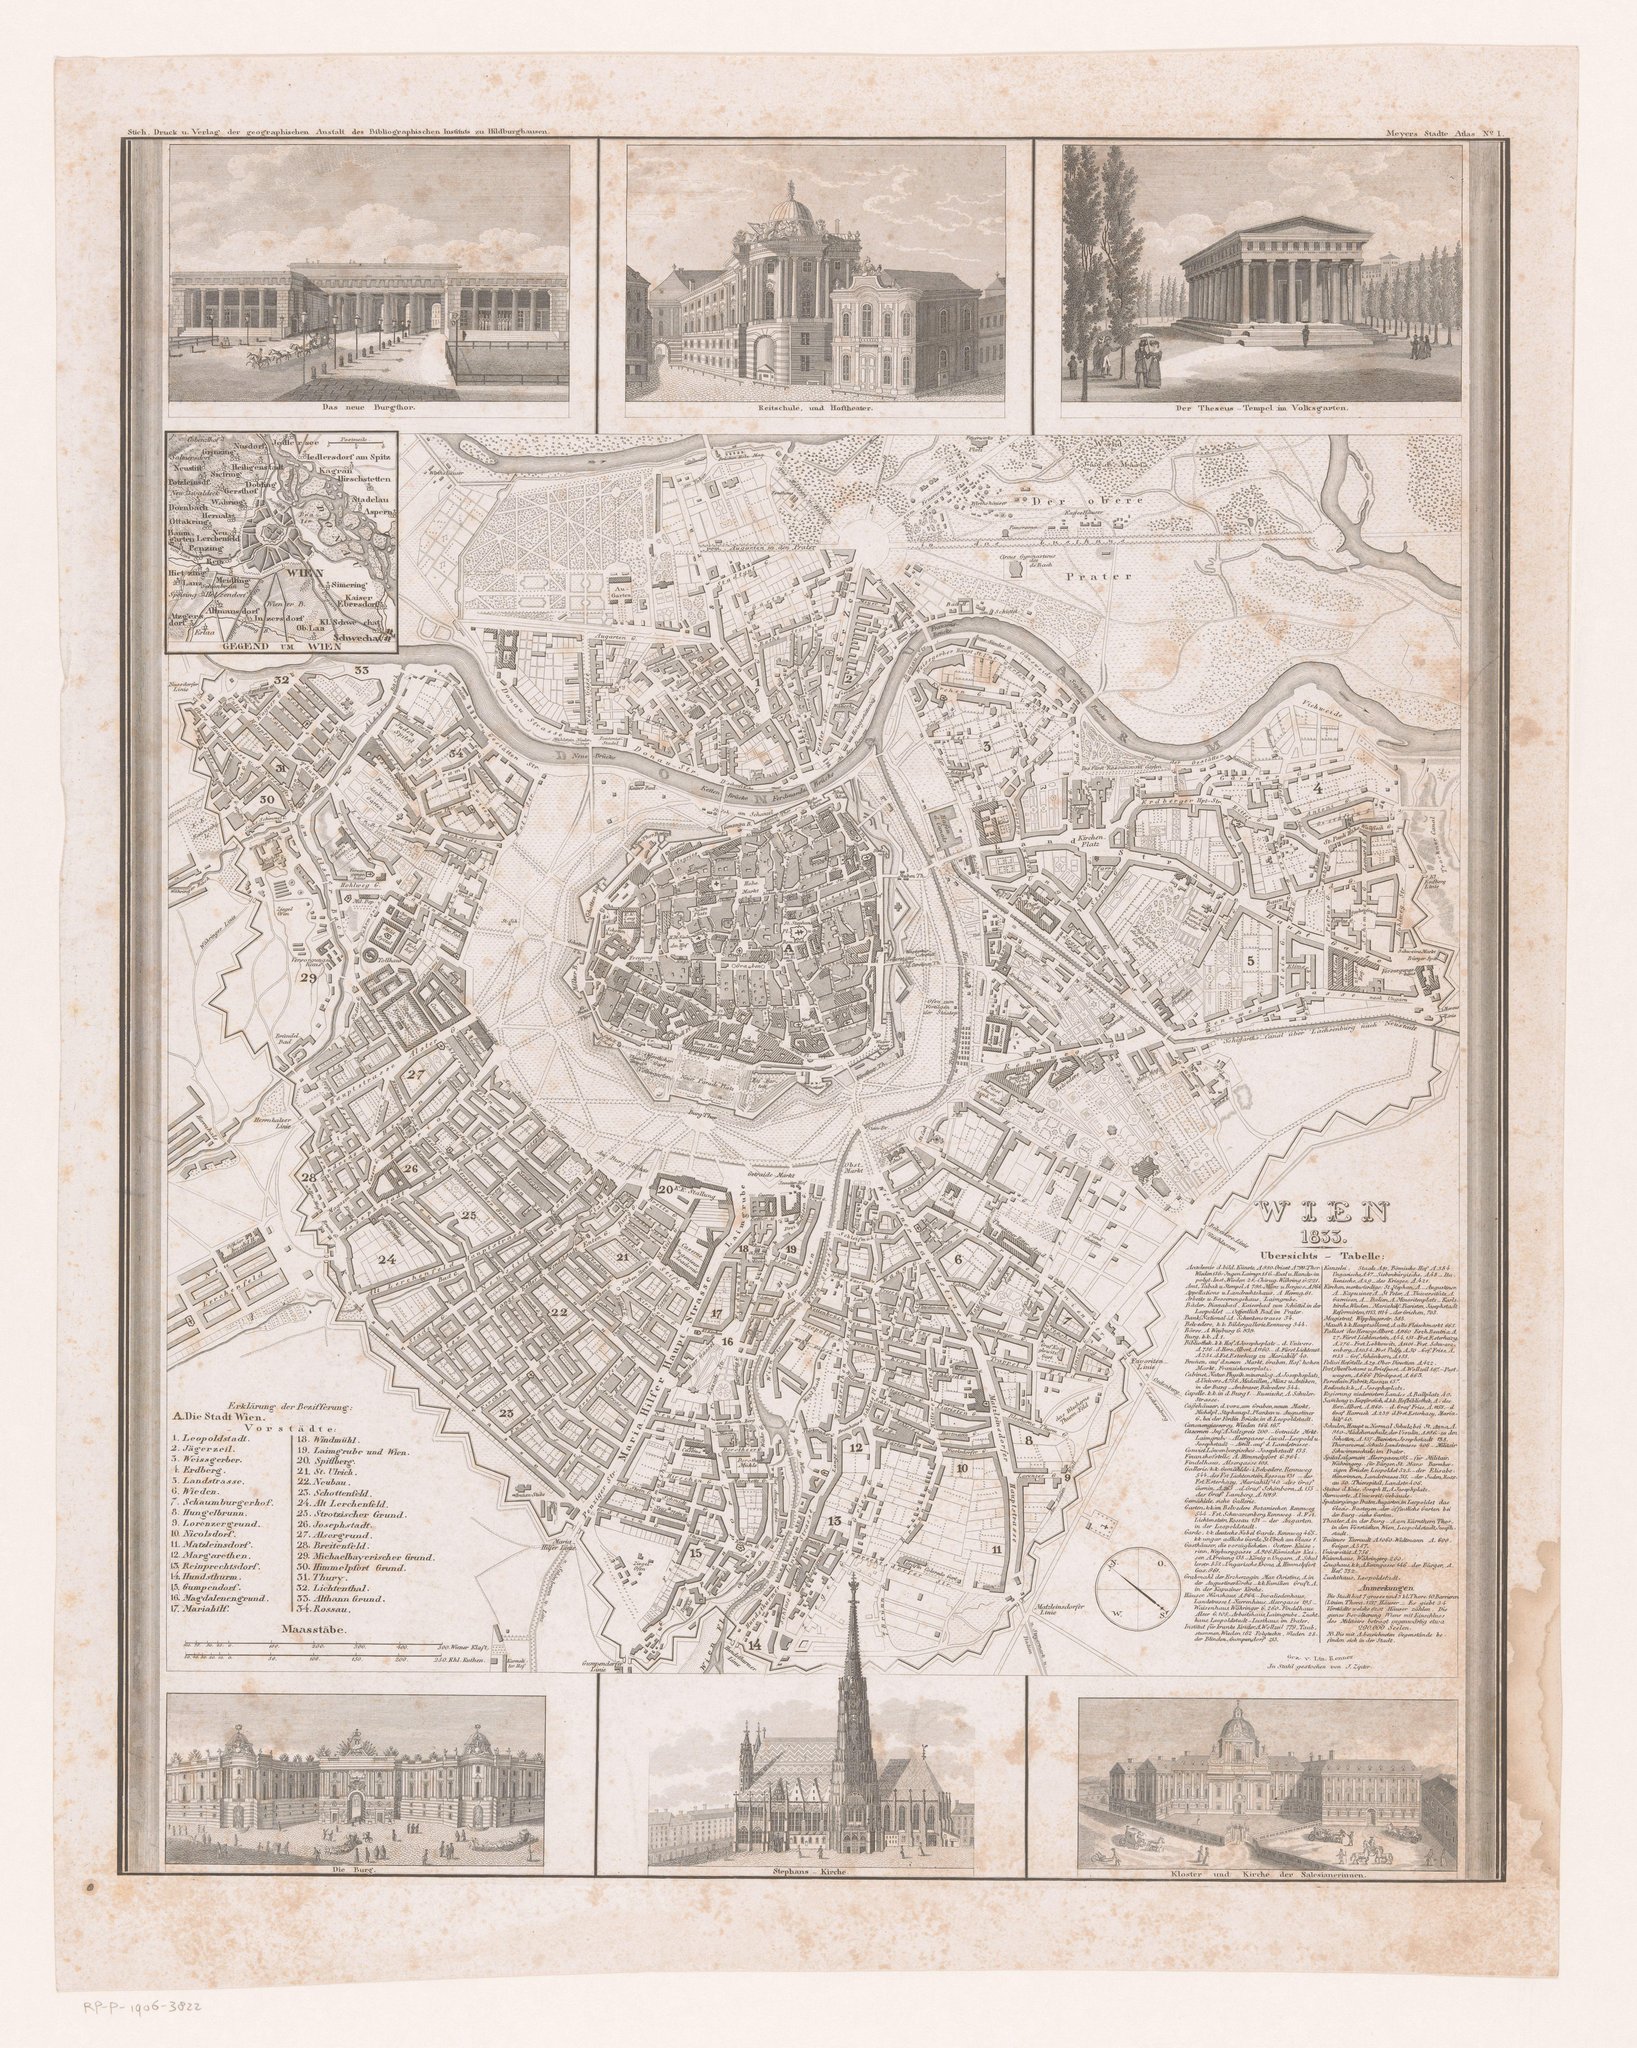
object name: print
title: Plattegrond van Wenen met zes details van gebouwen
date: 1833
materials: paper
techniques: engraving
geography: hildburghausen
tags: church (exterior), maps of cities, vienna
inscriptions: collector's mark: Lugt 2228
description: Prent gebruikt voor Joseph Meyers 'Stadte Atlas'.